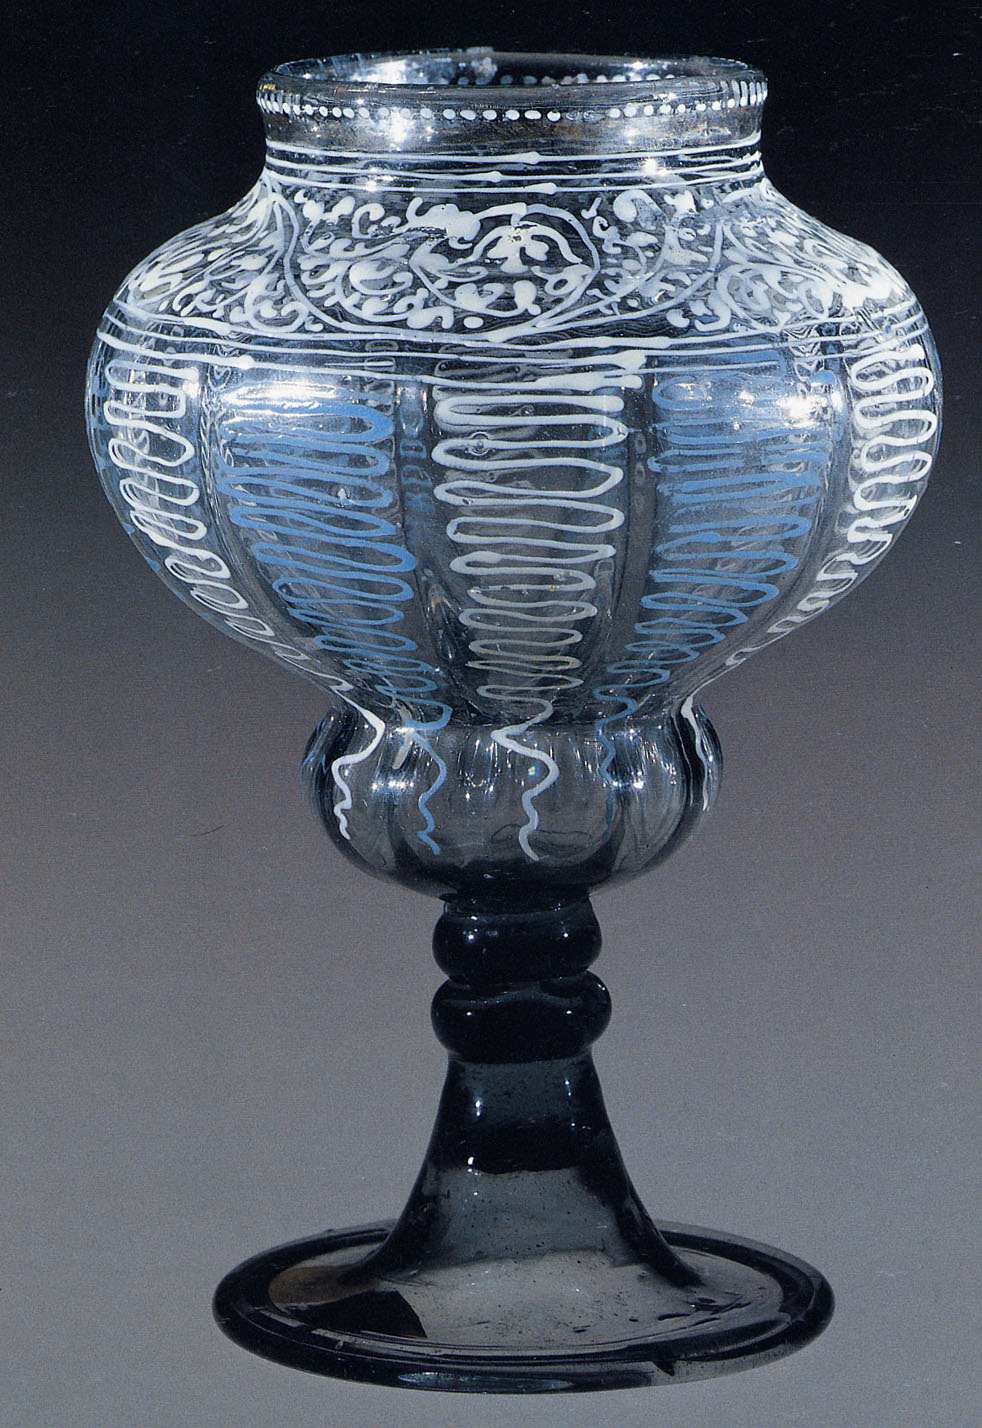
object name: goblet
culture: façon de venise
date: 1567-1600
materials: gilt, glass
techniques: glassblowing, enamel, molding